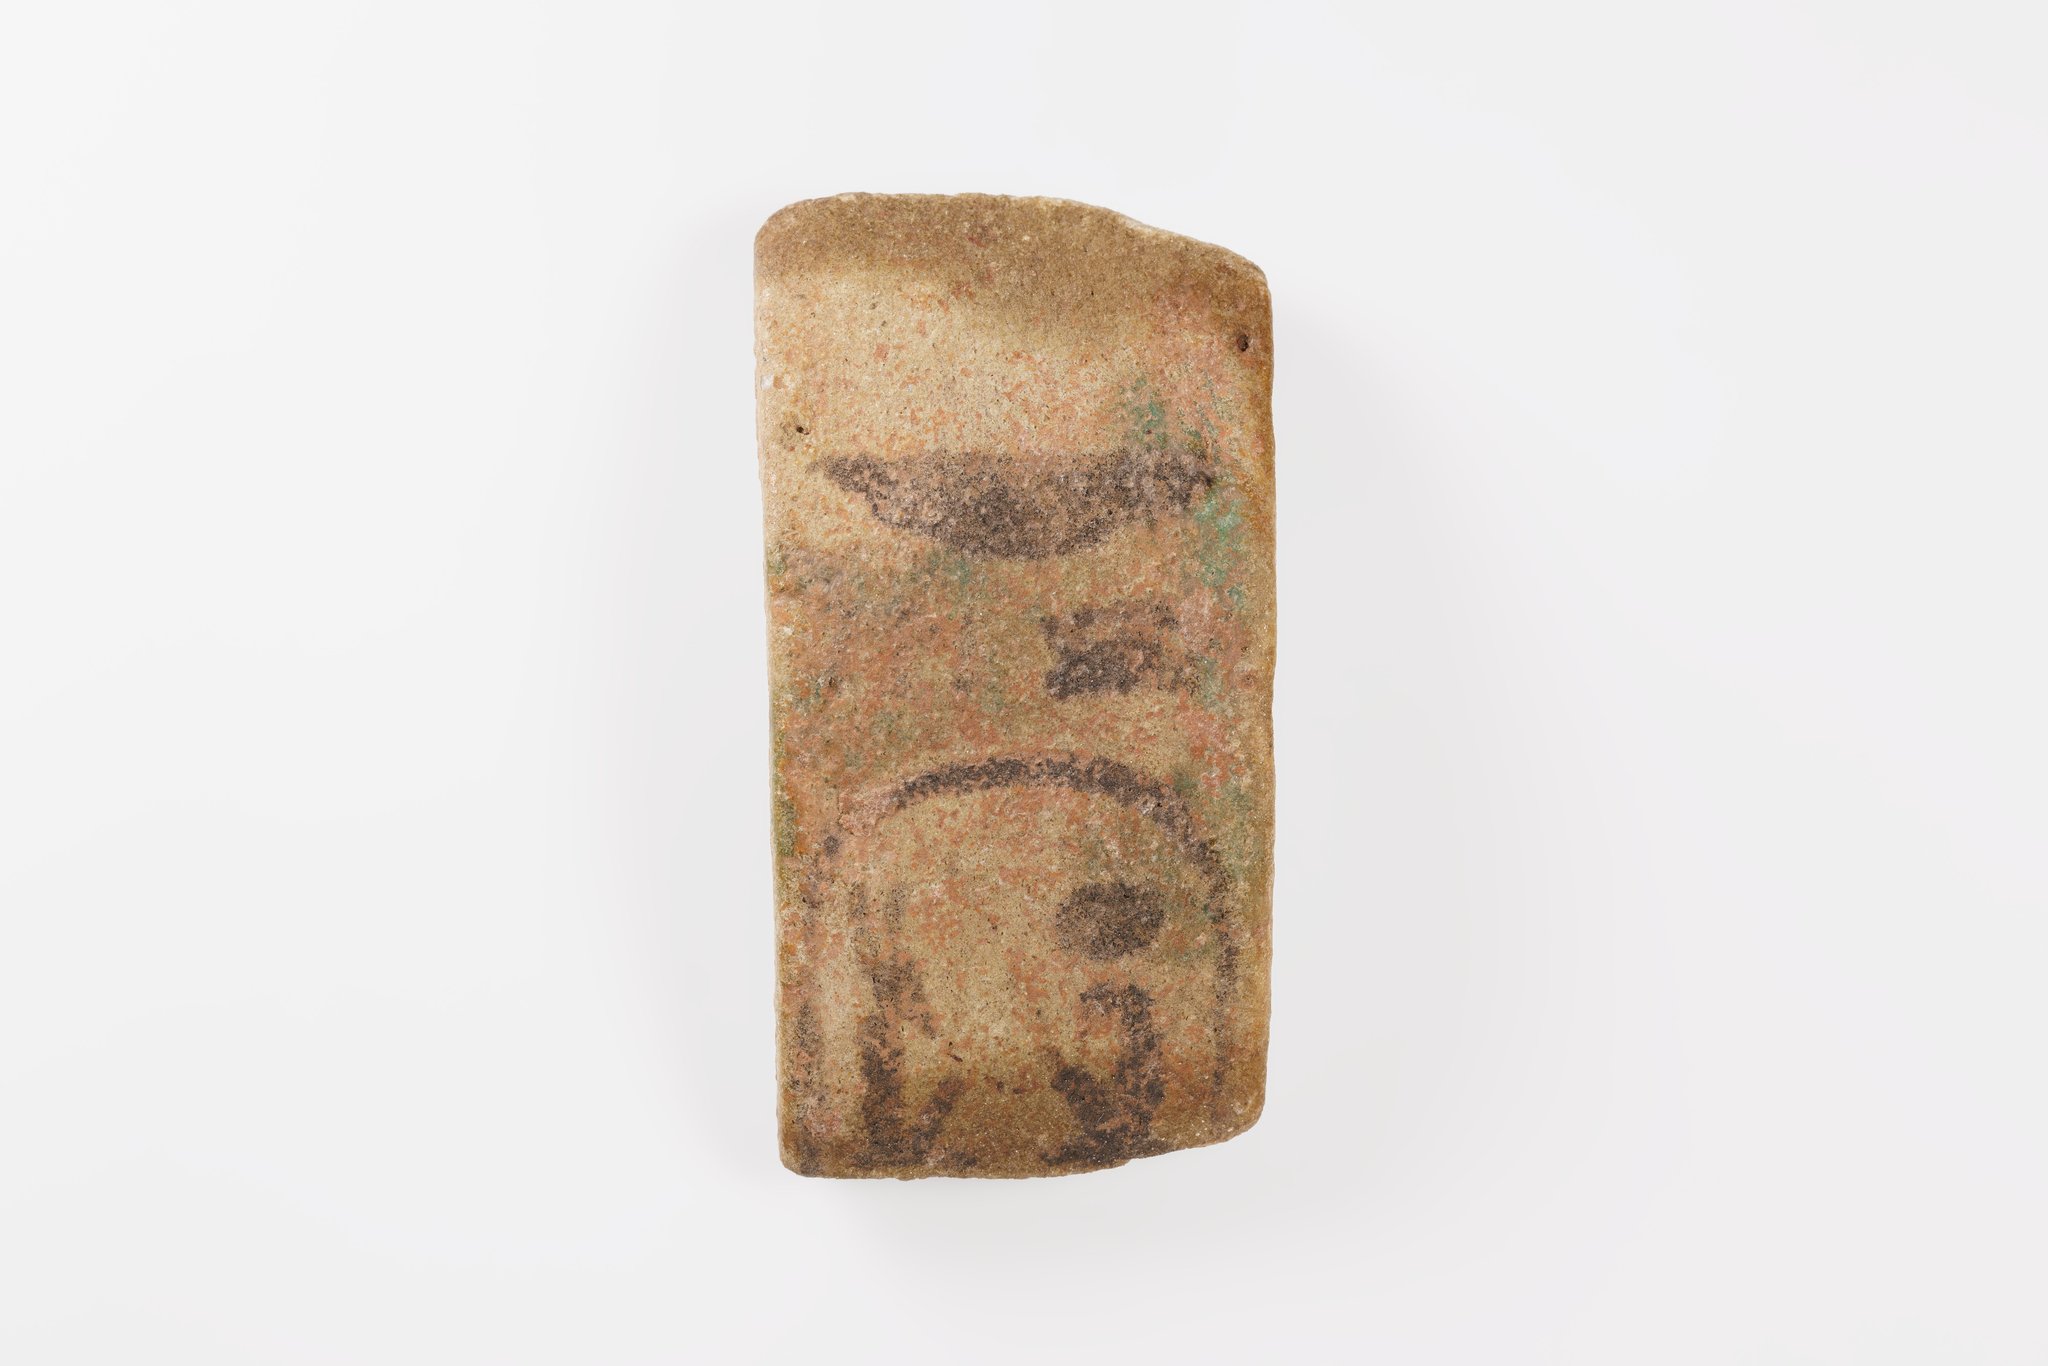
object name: votive bracelet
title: Fragment of a votive bracelet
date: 1295-1070 BCE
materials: faience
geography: egypt